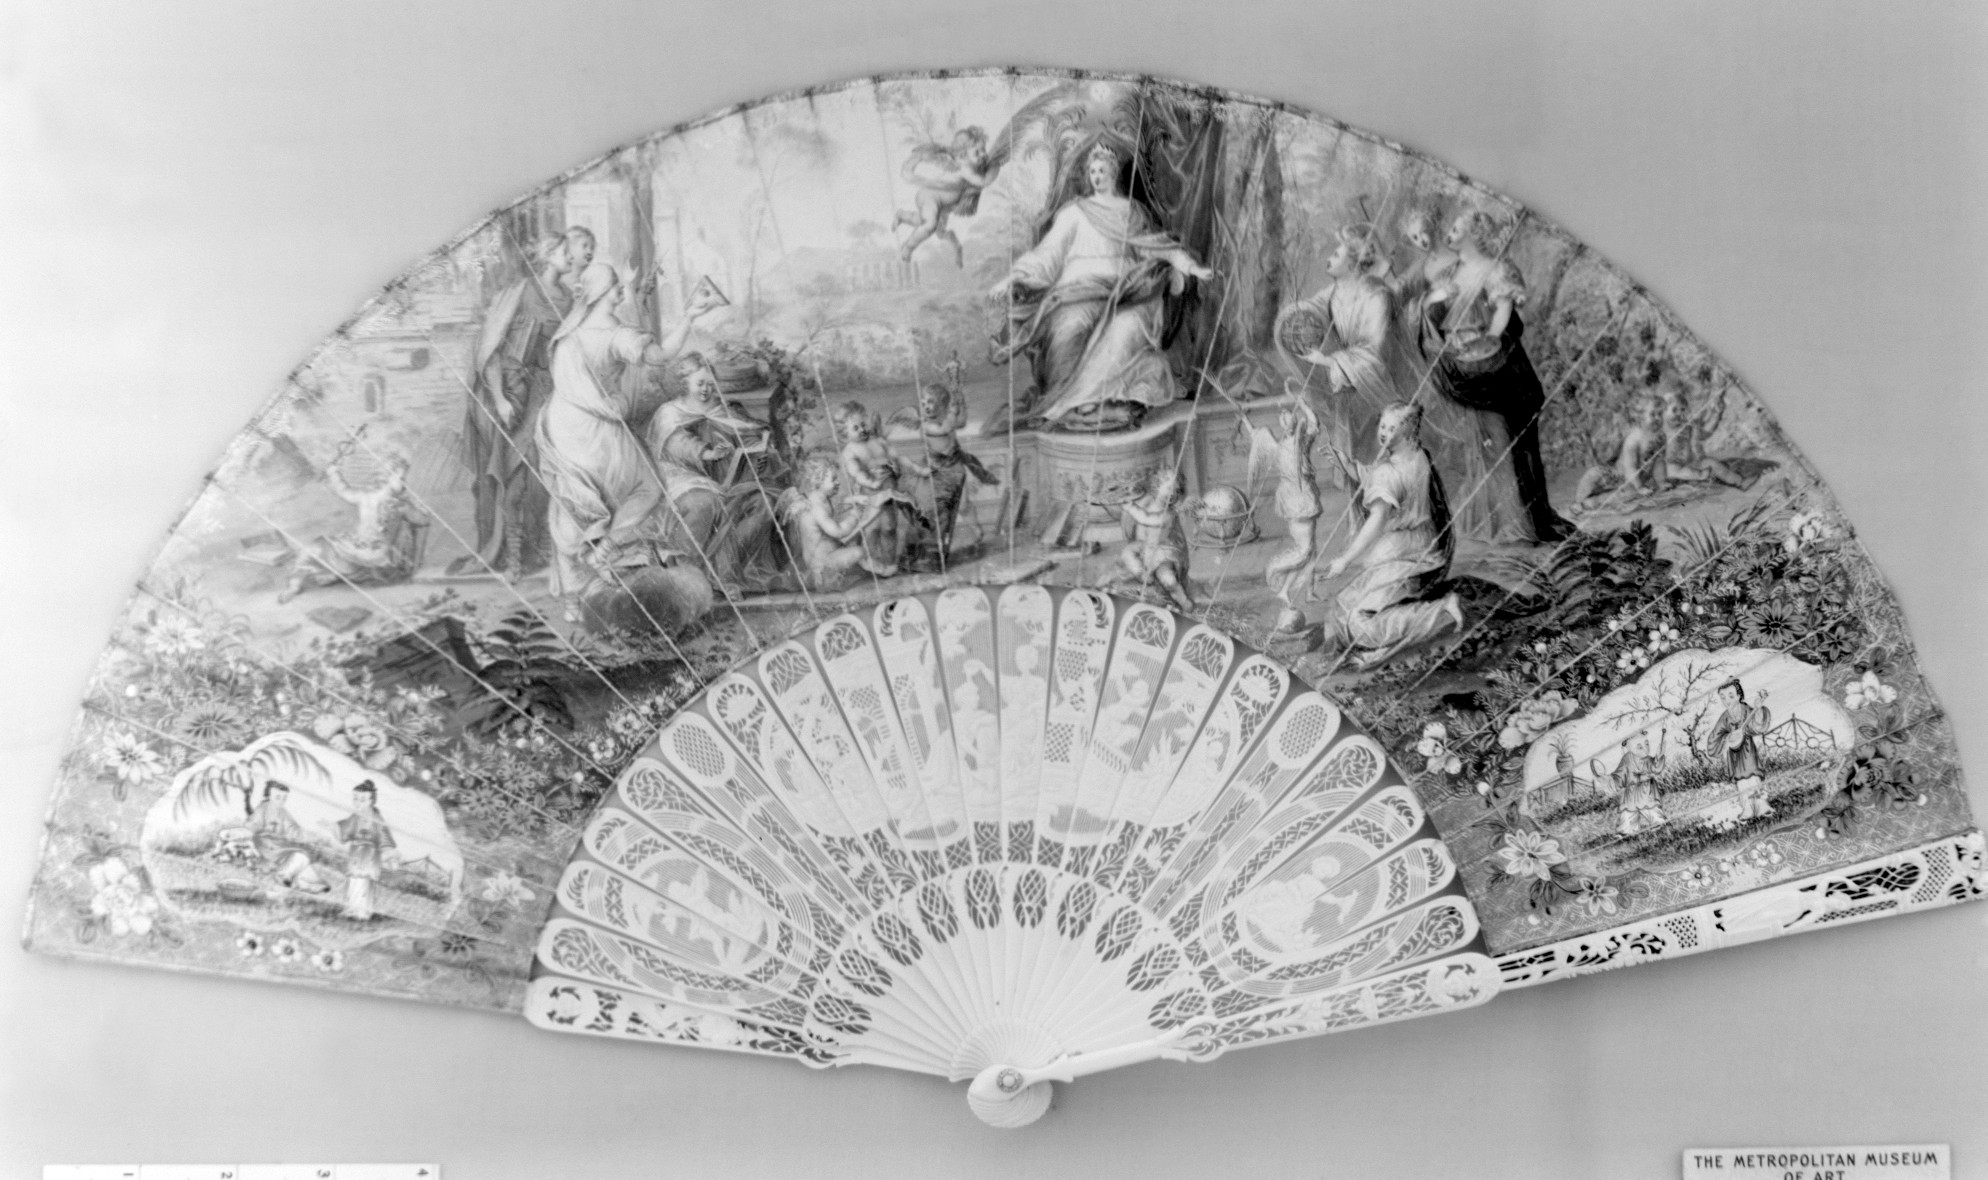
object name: fan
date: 1740-1750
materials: ivory, silk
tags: women,putti